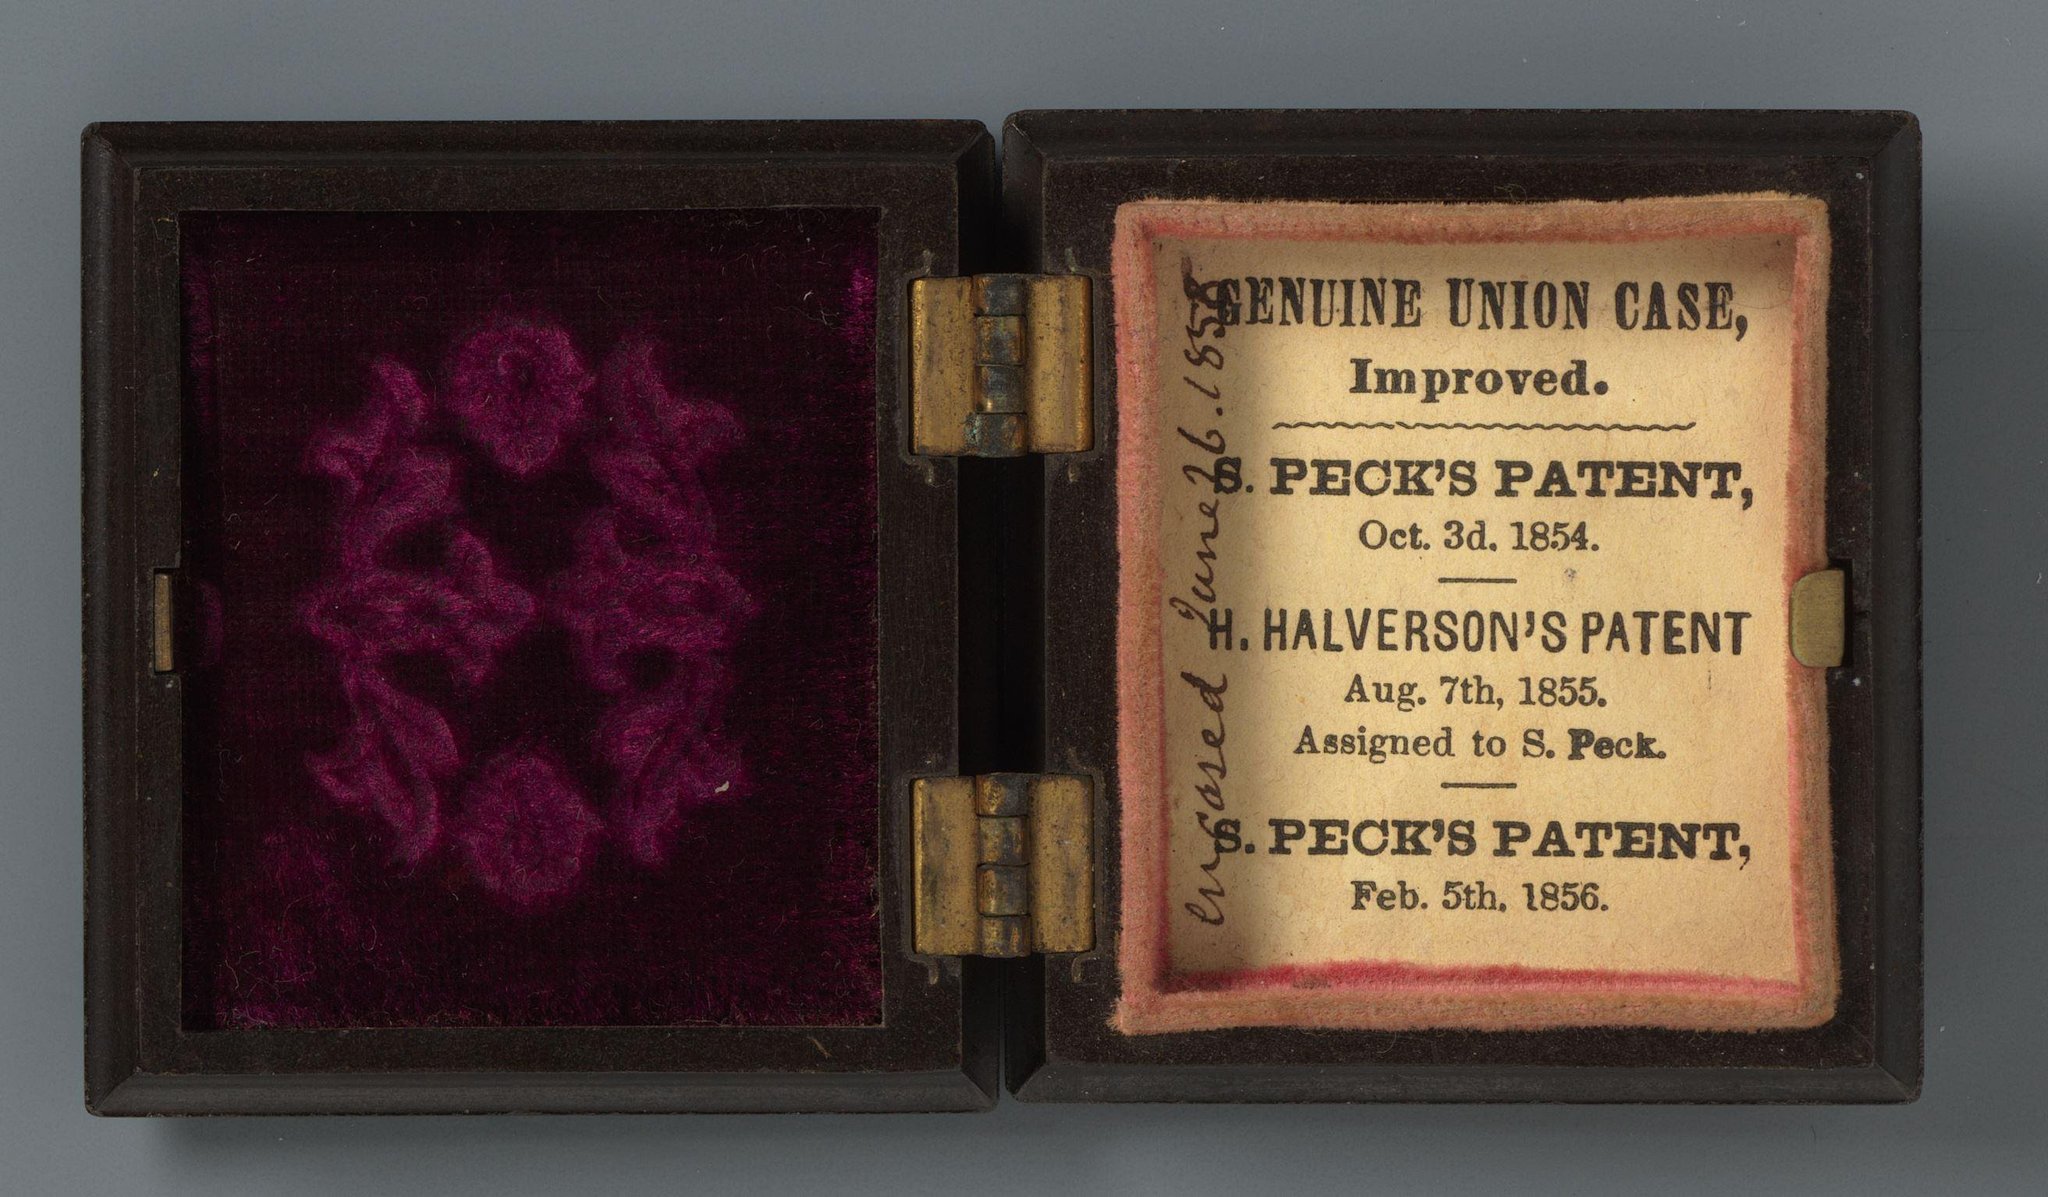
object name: union case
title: Genuine union case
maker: Anonymous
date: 1858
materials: metal, paper, plastic, velvet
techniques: letterpress printing, writing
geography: united states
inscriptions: inscription: ‘Genuine union case,/ Improved./ S. Peck's patent,/ Oct. 3d. 1854./ H. Halverson's patent/ Aug. 7th, 1855./ Assigned to S. Peck./ S. Peck's patent,/ Feb. 5th. 1856.’, inscription: ‘Encased June 26, 1858’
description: Lege union case, met tekst aan de binnenzijde.